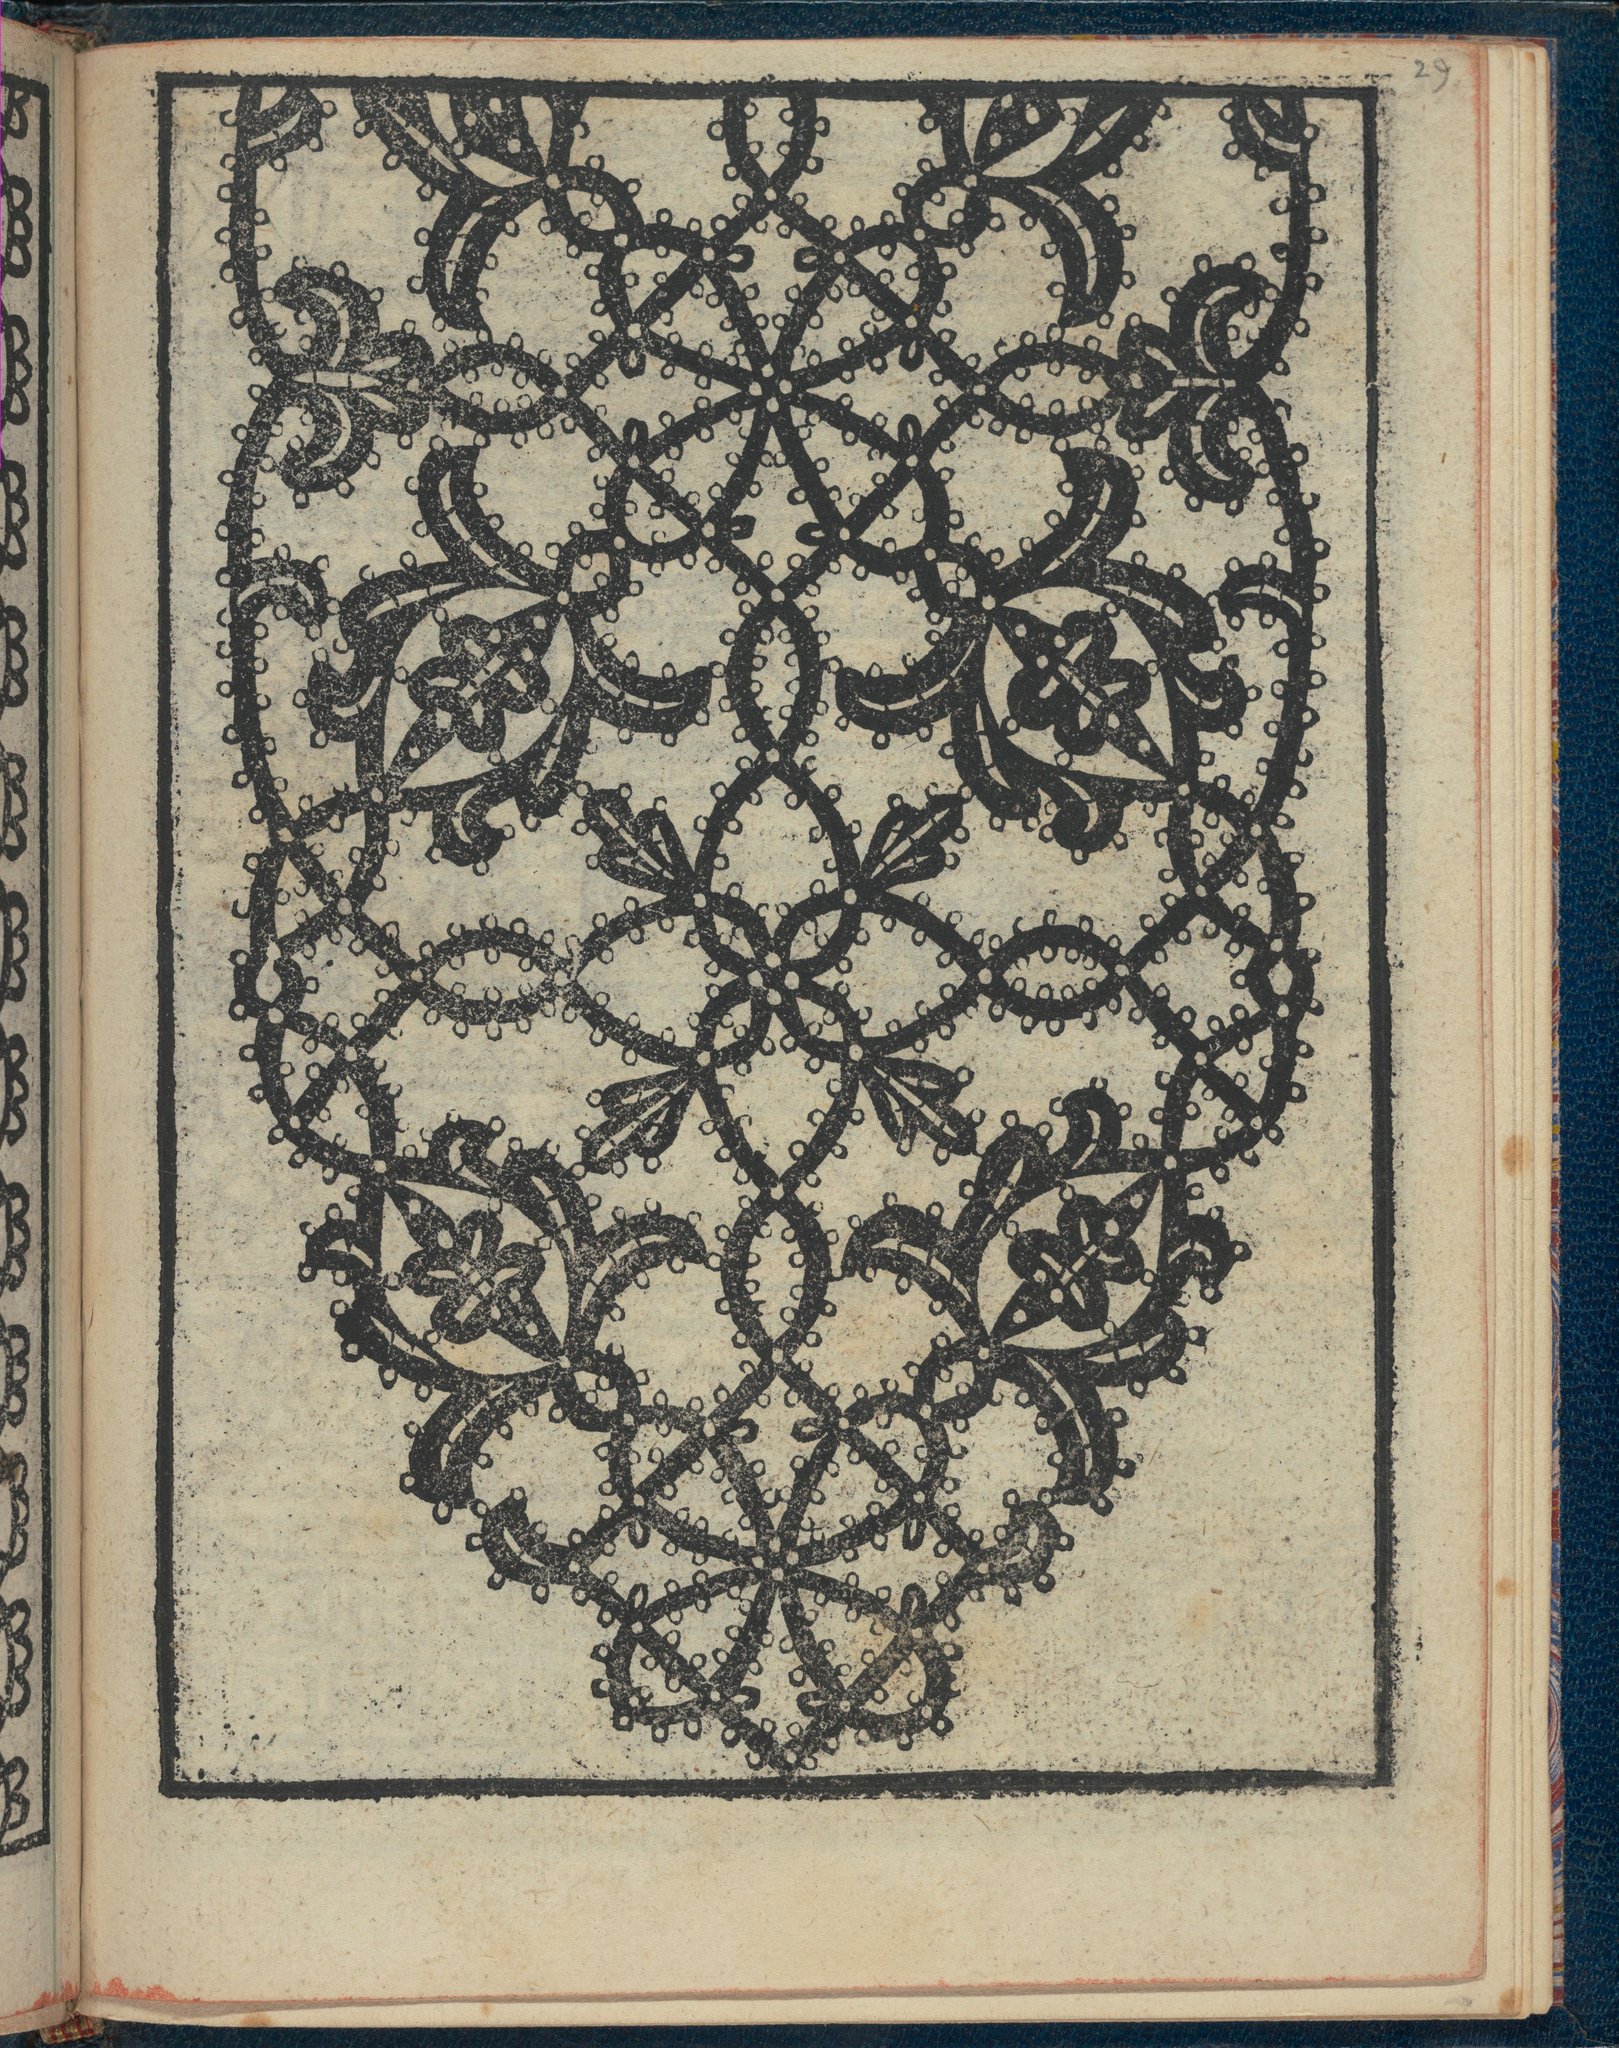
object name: book print ornament architecture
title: Le Pompe: Opera Nova, page 15 (recto)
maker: giovanni battista & marchio sessa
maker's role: publisher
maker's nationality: italian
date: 1557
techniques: woodcut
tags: ornament